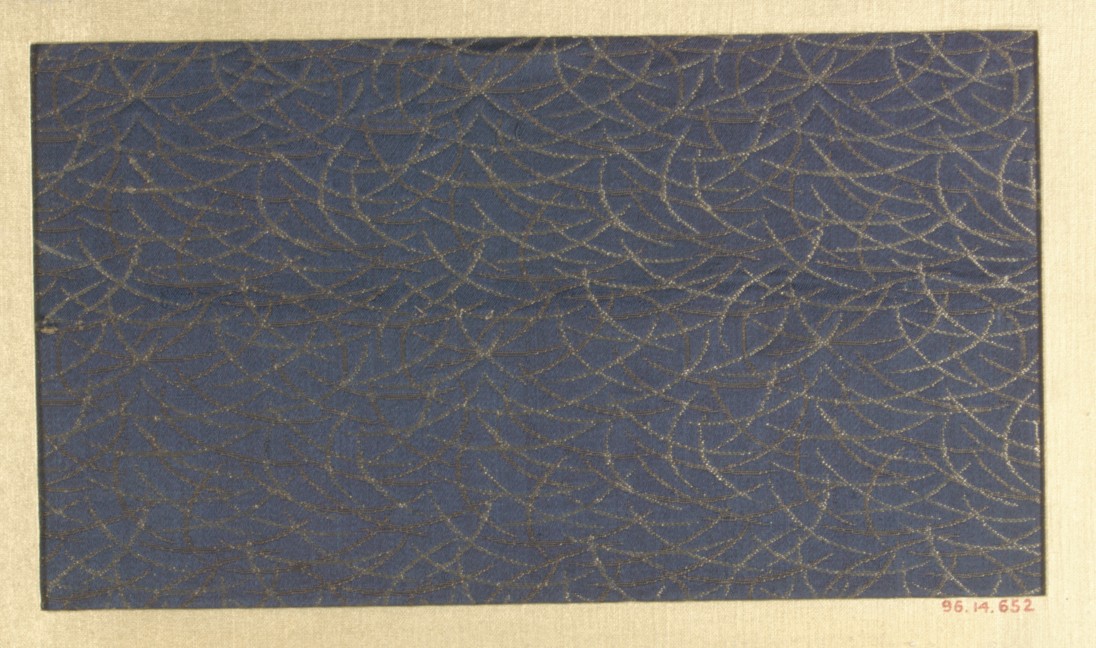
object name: piece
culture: japanese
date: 1701-1900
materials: silk